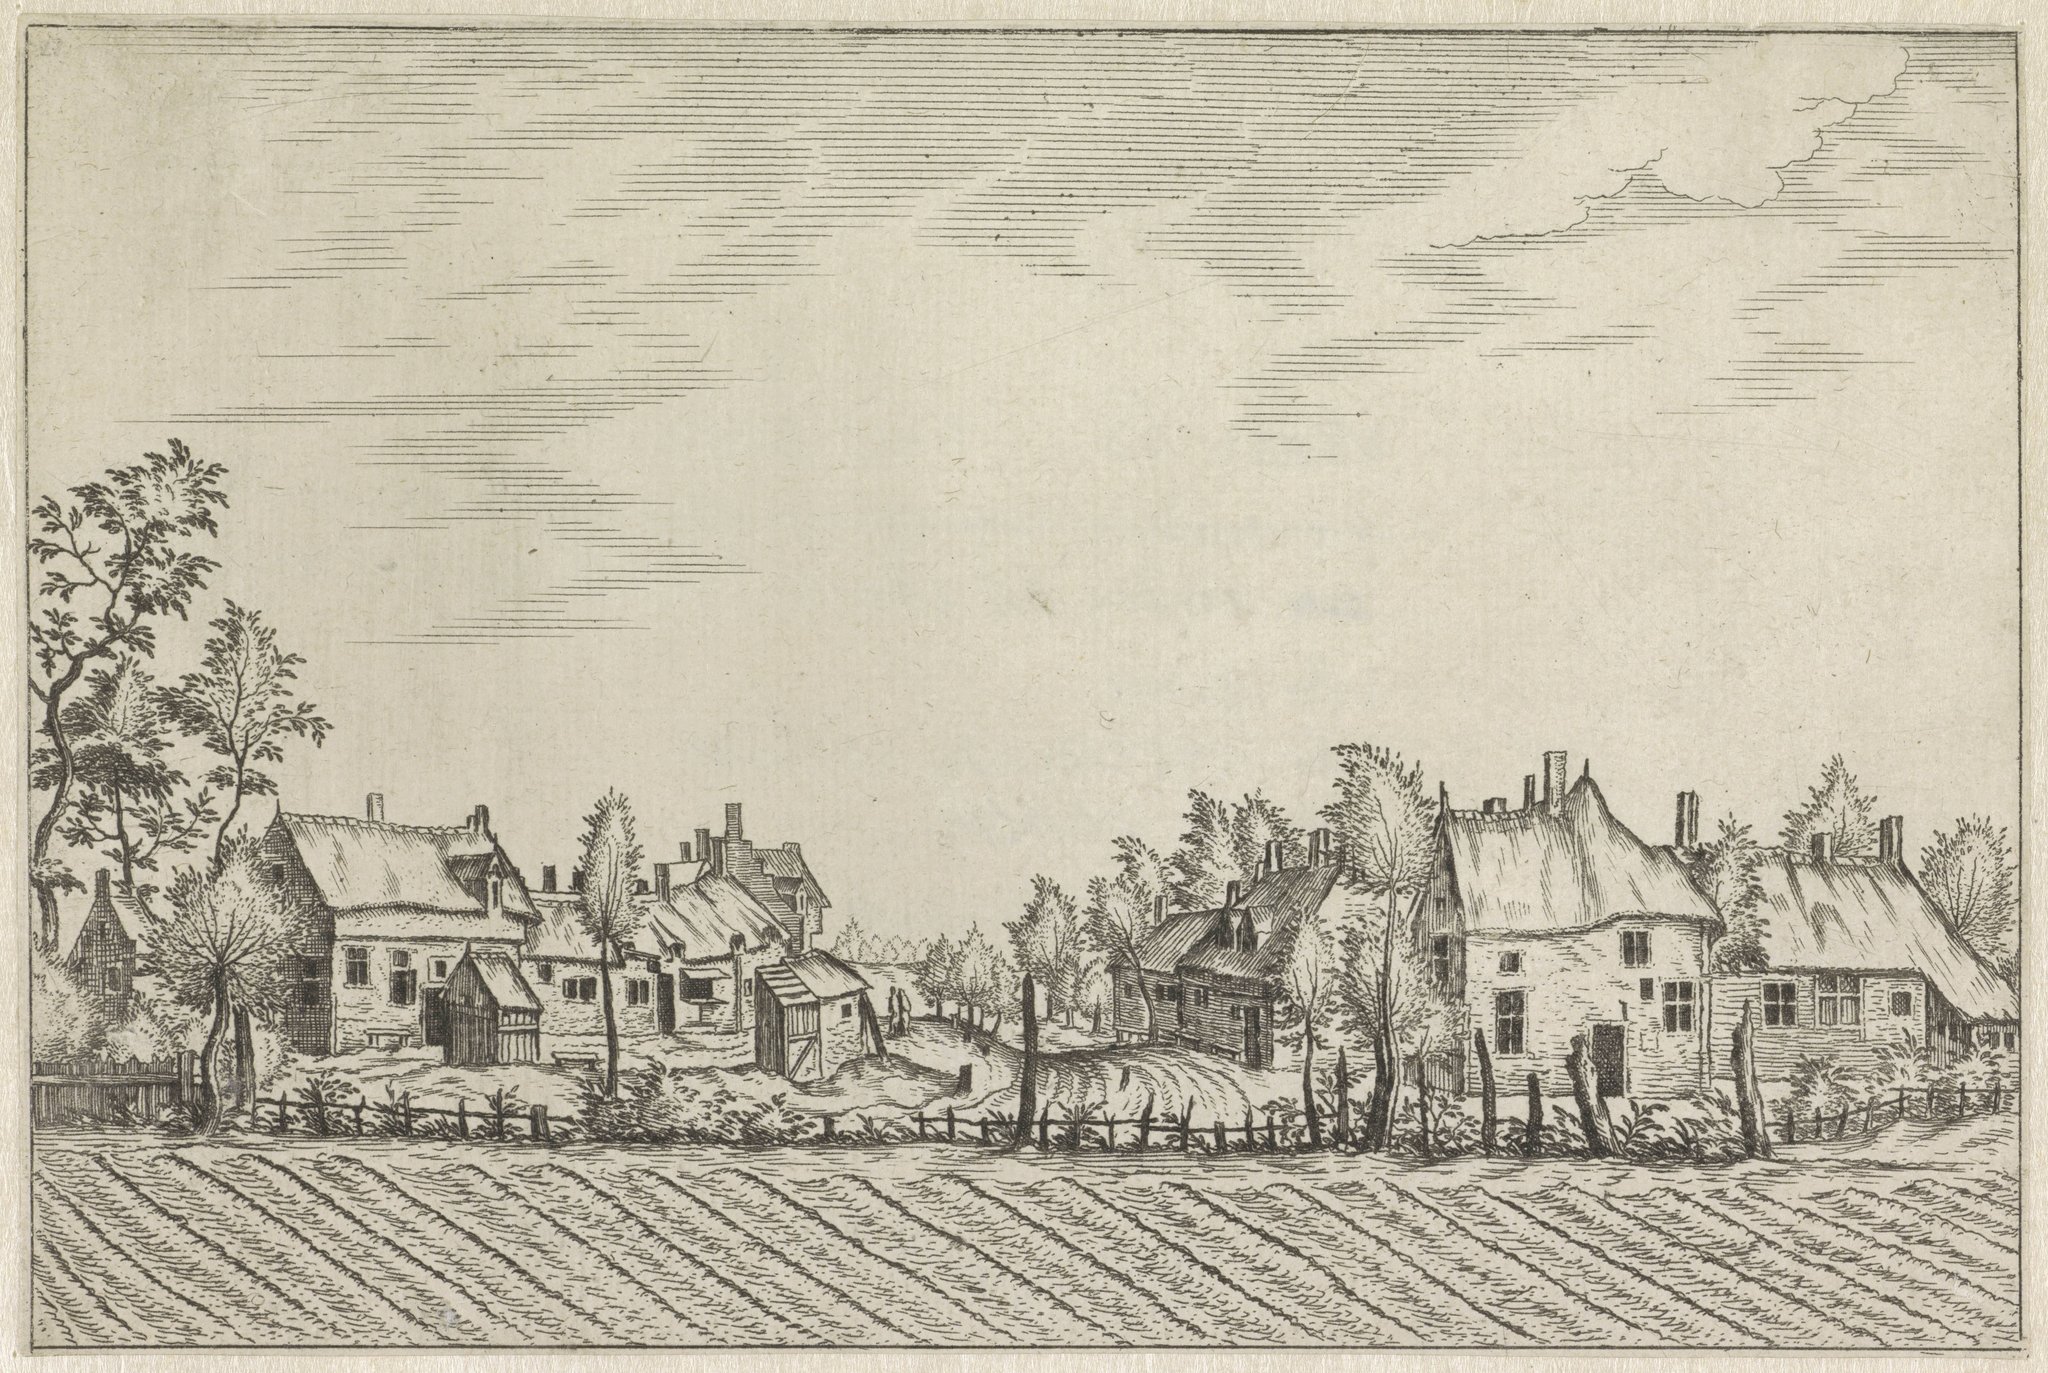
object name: print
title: Boerderijen bij een geploegd veld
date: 1559-1561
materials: paper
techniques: etching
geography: antwerp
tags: ploughed field, farm (building)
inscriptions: collector's mark: Lugt 2760, collector's mark: Lugt 2228